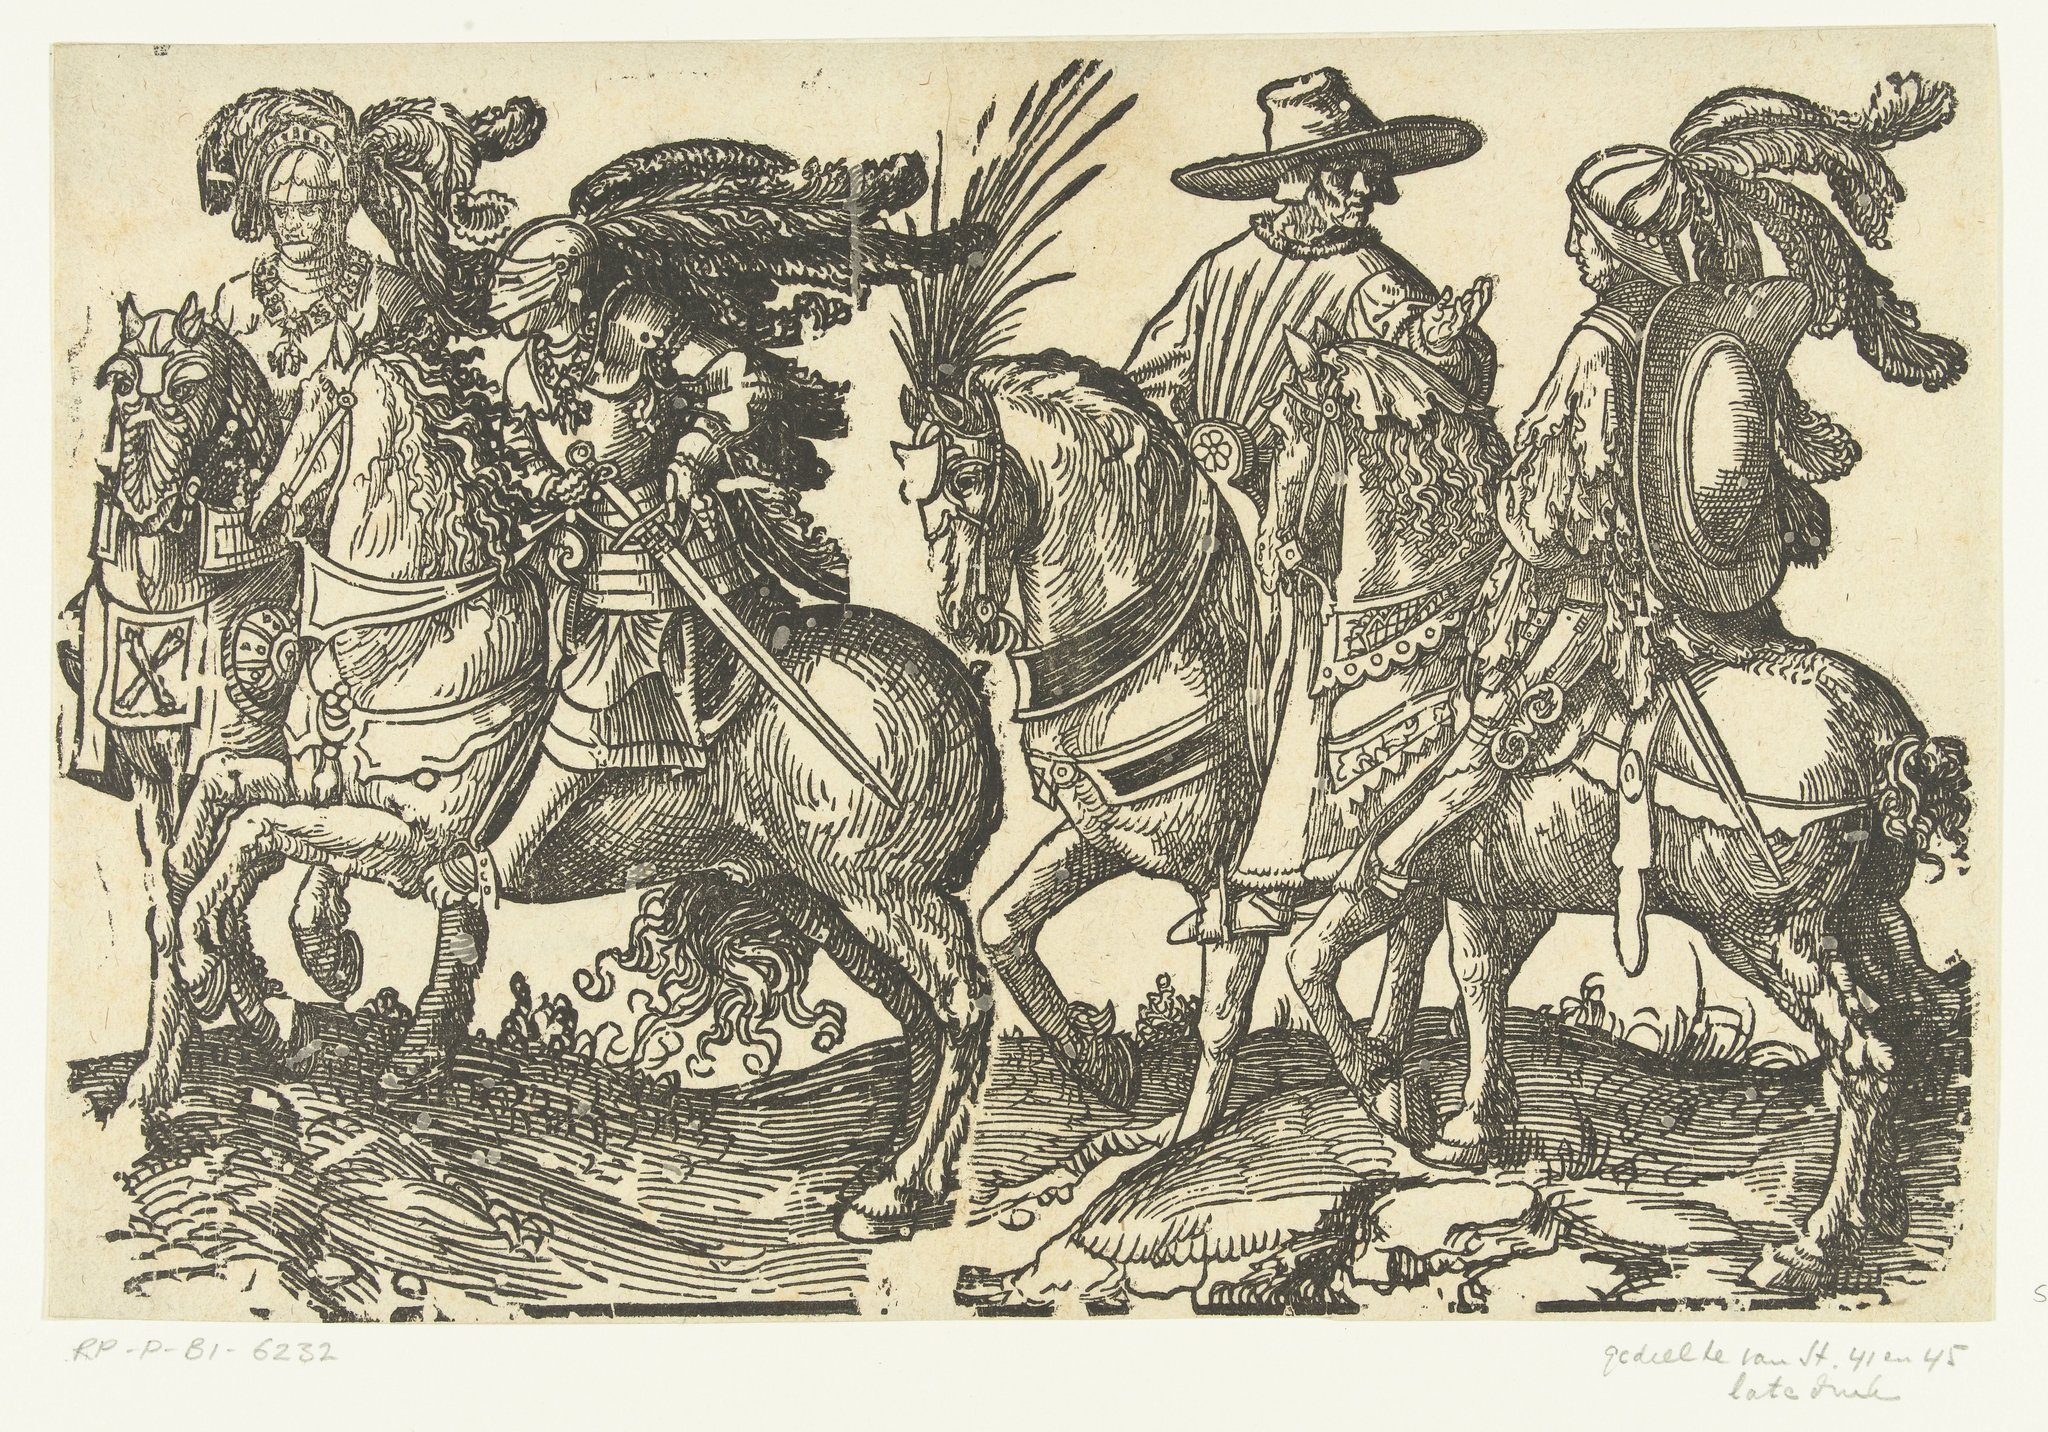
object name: print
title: De Graven en Gravinnen van Holland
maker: jacob cornelisz van oostsanen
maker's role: draughtsman, painter, print maker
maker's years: 1475-1533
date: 1518-1533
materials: paper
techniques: woodcut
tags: bruges, philip iii the good, earl, charles the bold (duke of burgundy), riding a horse, ass, or mule; rider, horseman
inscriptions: collector's mark: Lugt 240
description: Prent is later toegevoegd aan de serie. Gedrukt van twee blokken. Rechts twee niet geïdentificeerde mannen te paard. Links Filips de Goede en Karel de Stoute, gedrukt van een blok dat eerder is gebruikt als rechter deel van een blad uit de oorspronkelijke serie Graven en Gravinnen van Holland.